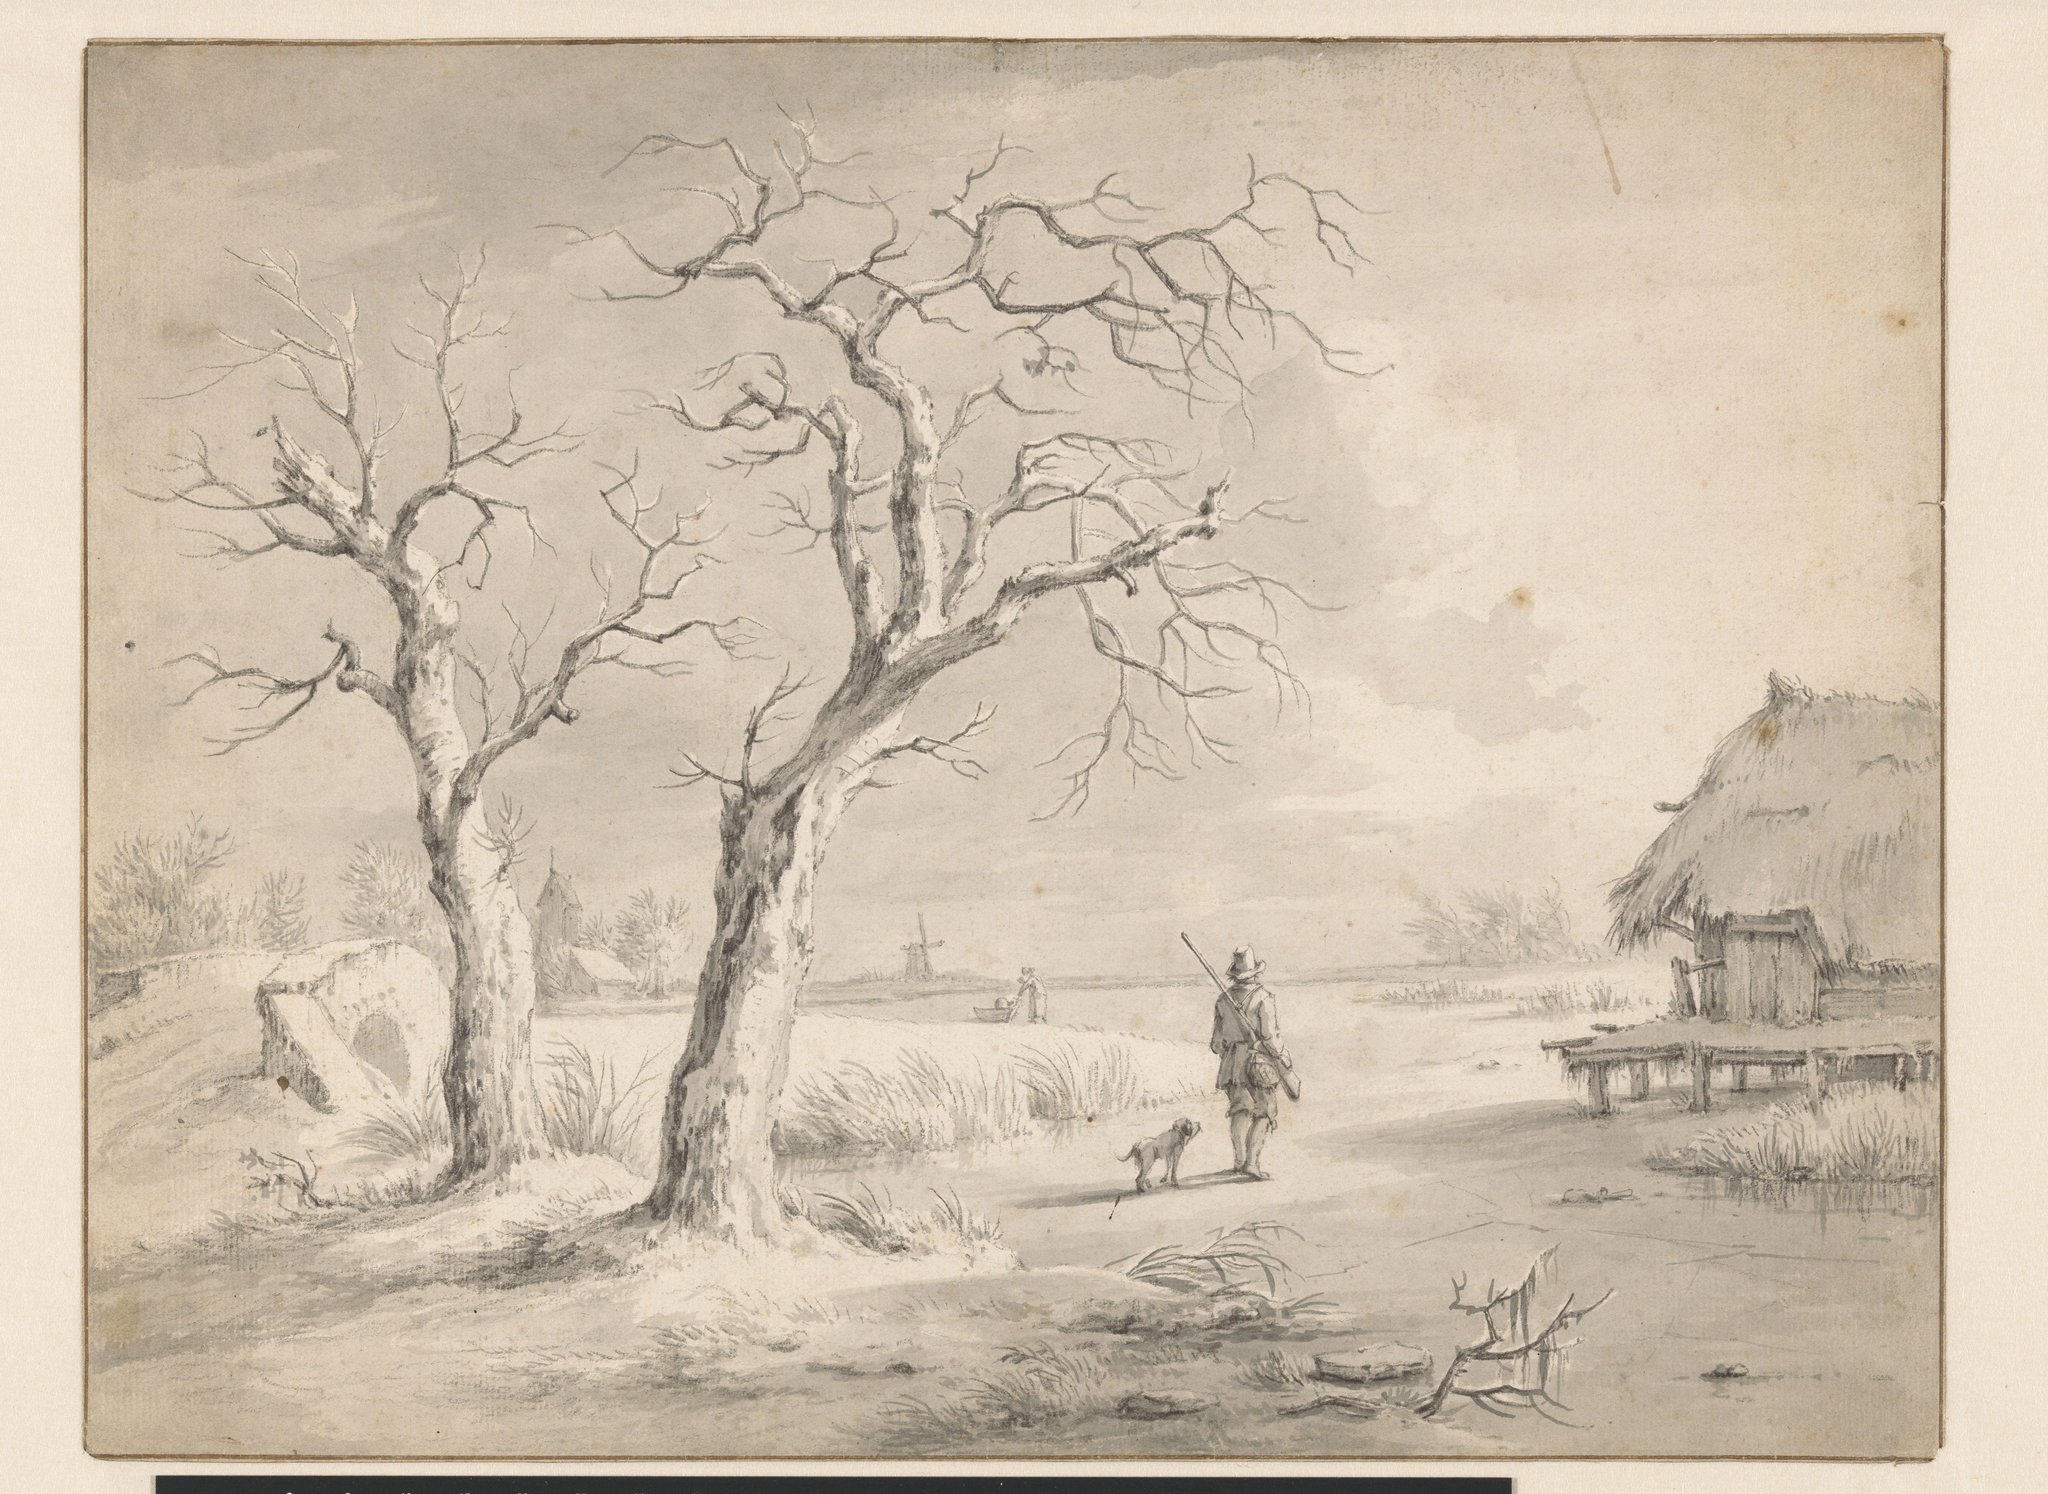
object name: drawing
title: Winterlandschap met jager op het ijs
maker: Anonymous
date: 1800-1900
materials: chalk, paper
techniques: brush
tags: ice ~ freezing weather